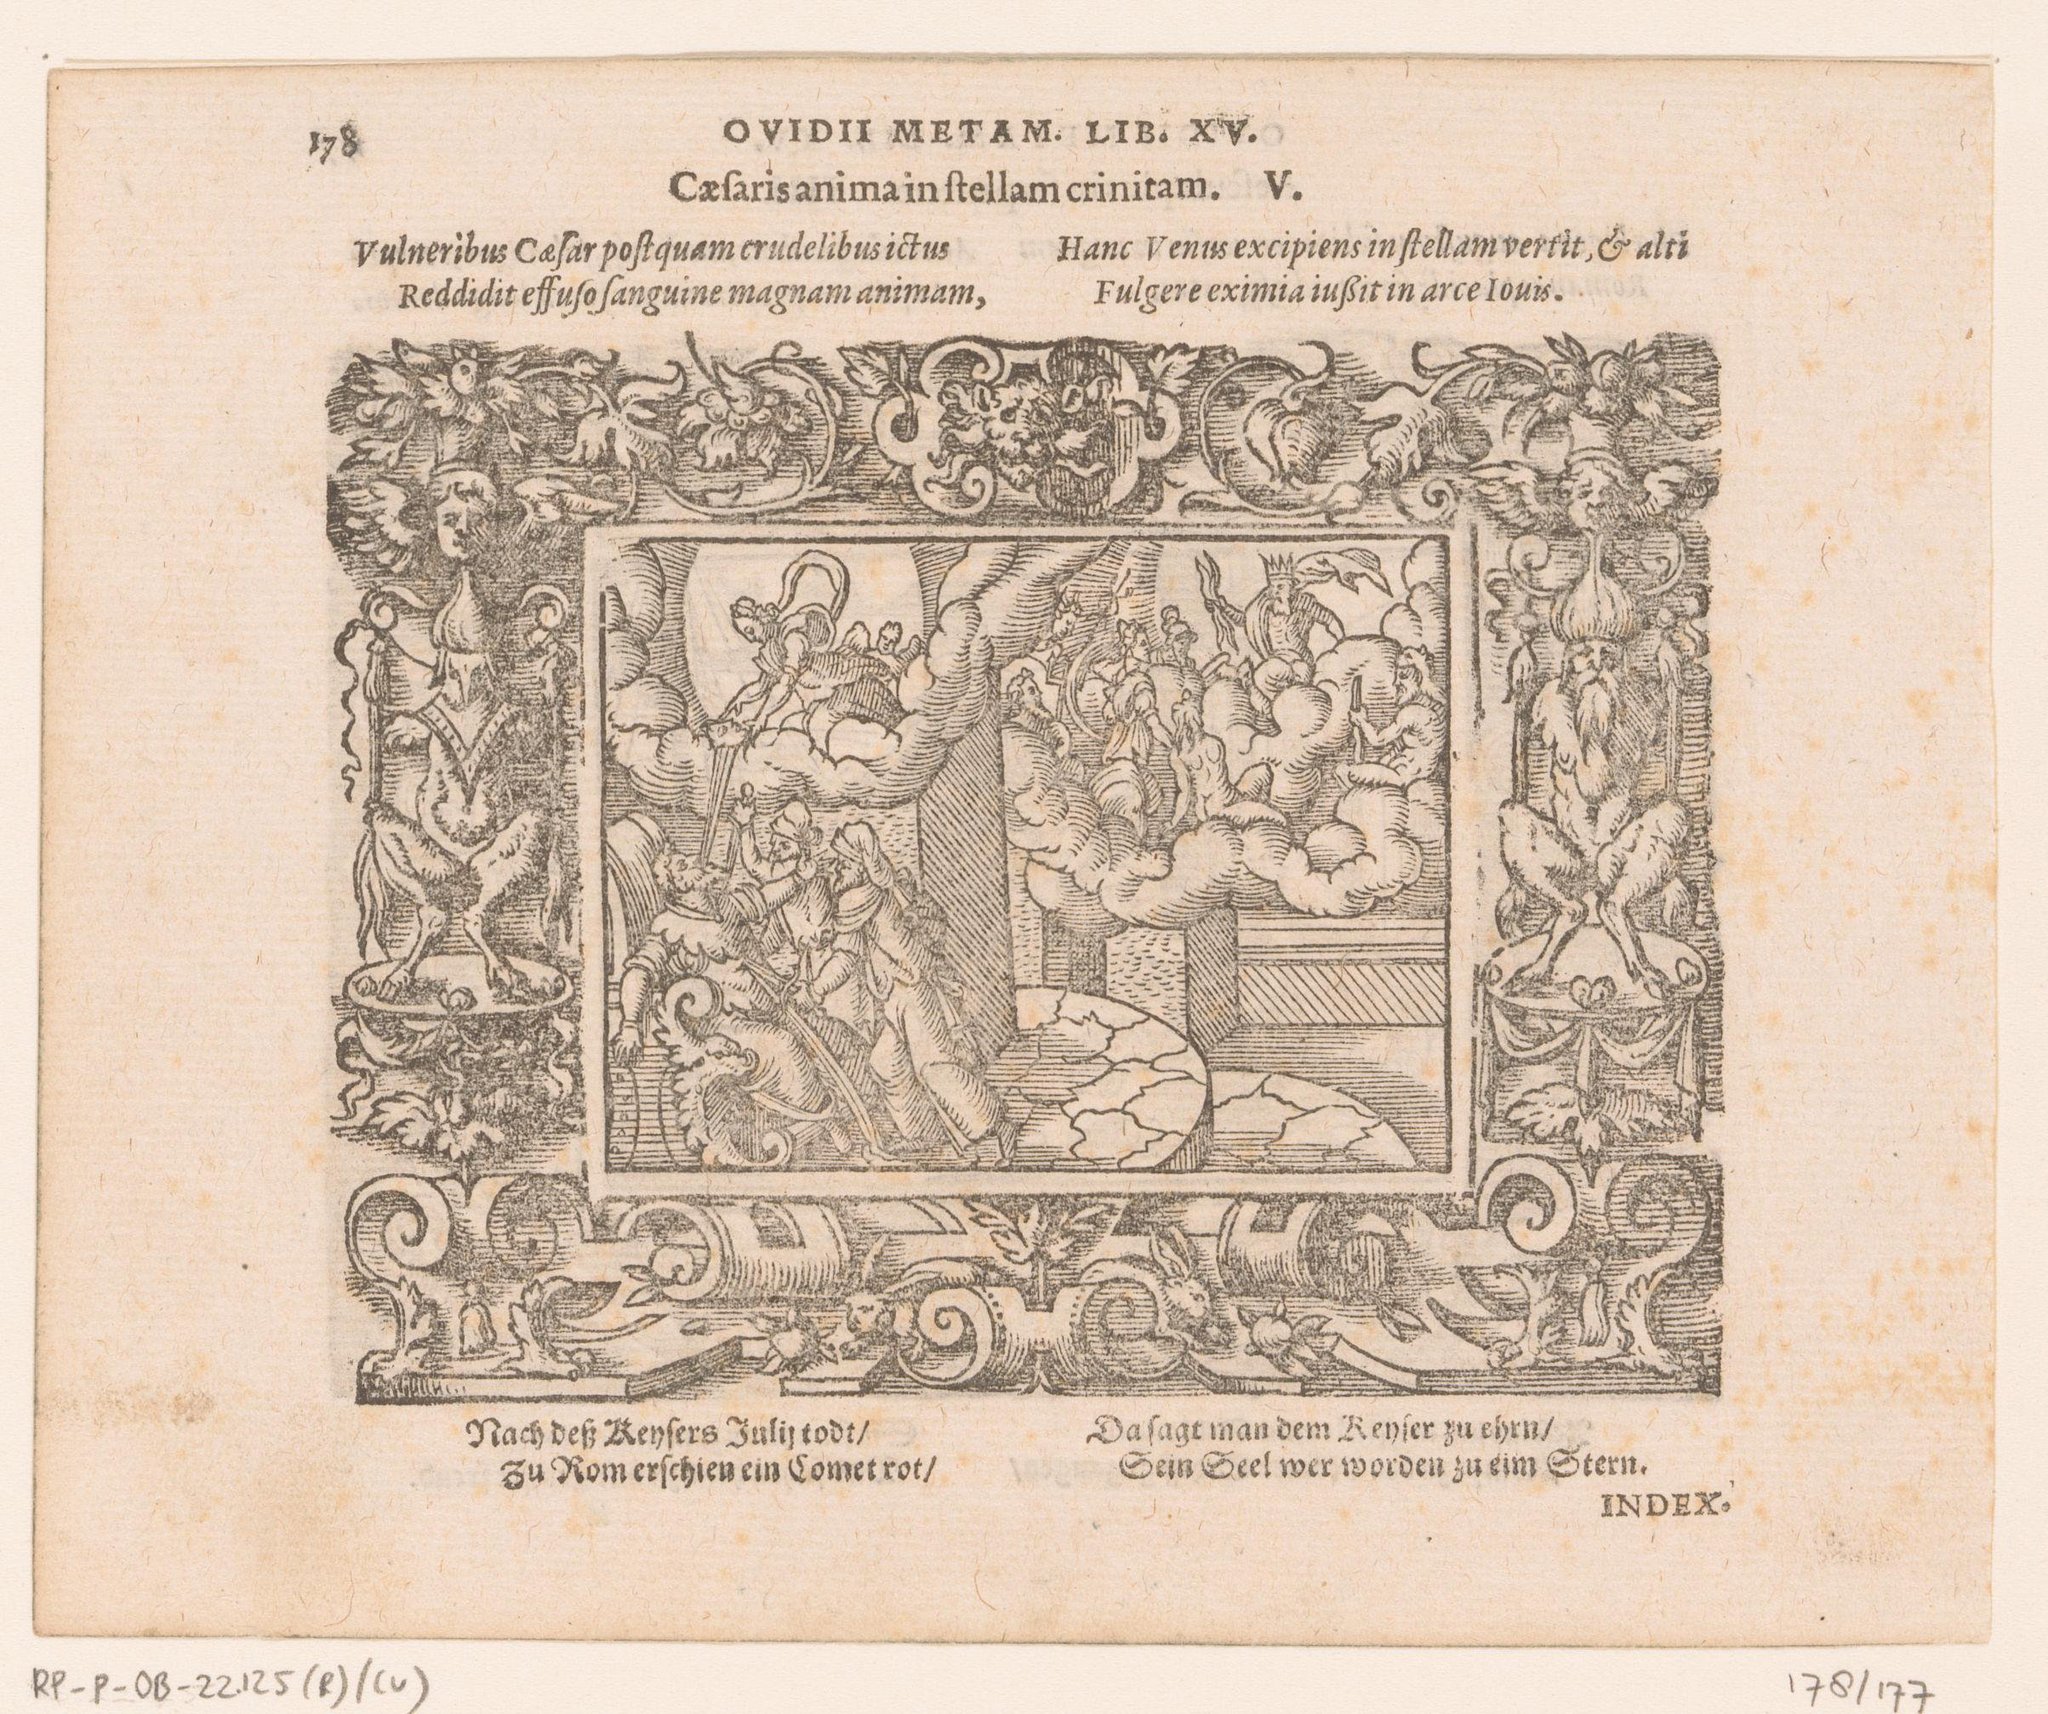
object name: book illustration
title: Caesaris anima in stellam crinitam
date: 1569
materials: paper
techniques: letterpress printing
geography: frankfurt am main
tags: apotheosis of caesar; his soul is changed into a comet by venus, scrollwork, strapwork ~ ornament, death of caesar, i.e. the murder of caesar: he is slain in the senate at the foot of pompey's statue, exclaiming 'et tu brute'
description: Illustratie bij de Metamorfosen van Ovidius, afkomstig uit de publicatie: Posthius, Johannes. Tetrasticha in Ovidii metam. Frankfurt am Main: Georg Rab en Sigmund Feyerabend en erven Weigand Han, 1569. De voorstellingen en ornamentranden van deze boekillustraties zijn van twee aparte blokken gedrukt. Beide werden afzonderlijk van elkaar ook gebruikt voor andere publicaties, en de ornamentranden werden eveneens binnen deze publicatie meerdere keren gebruikt.